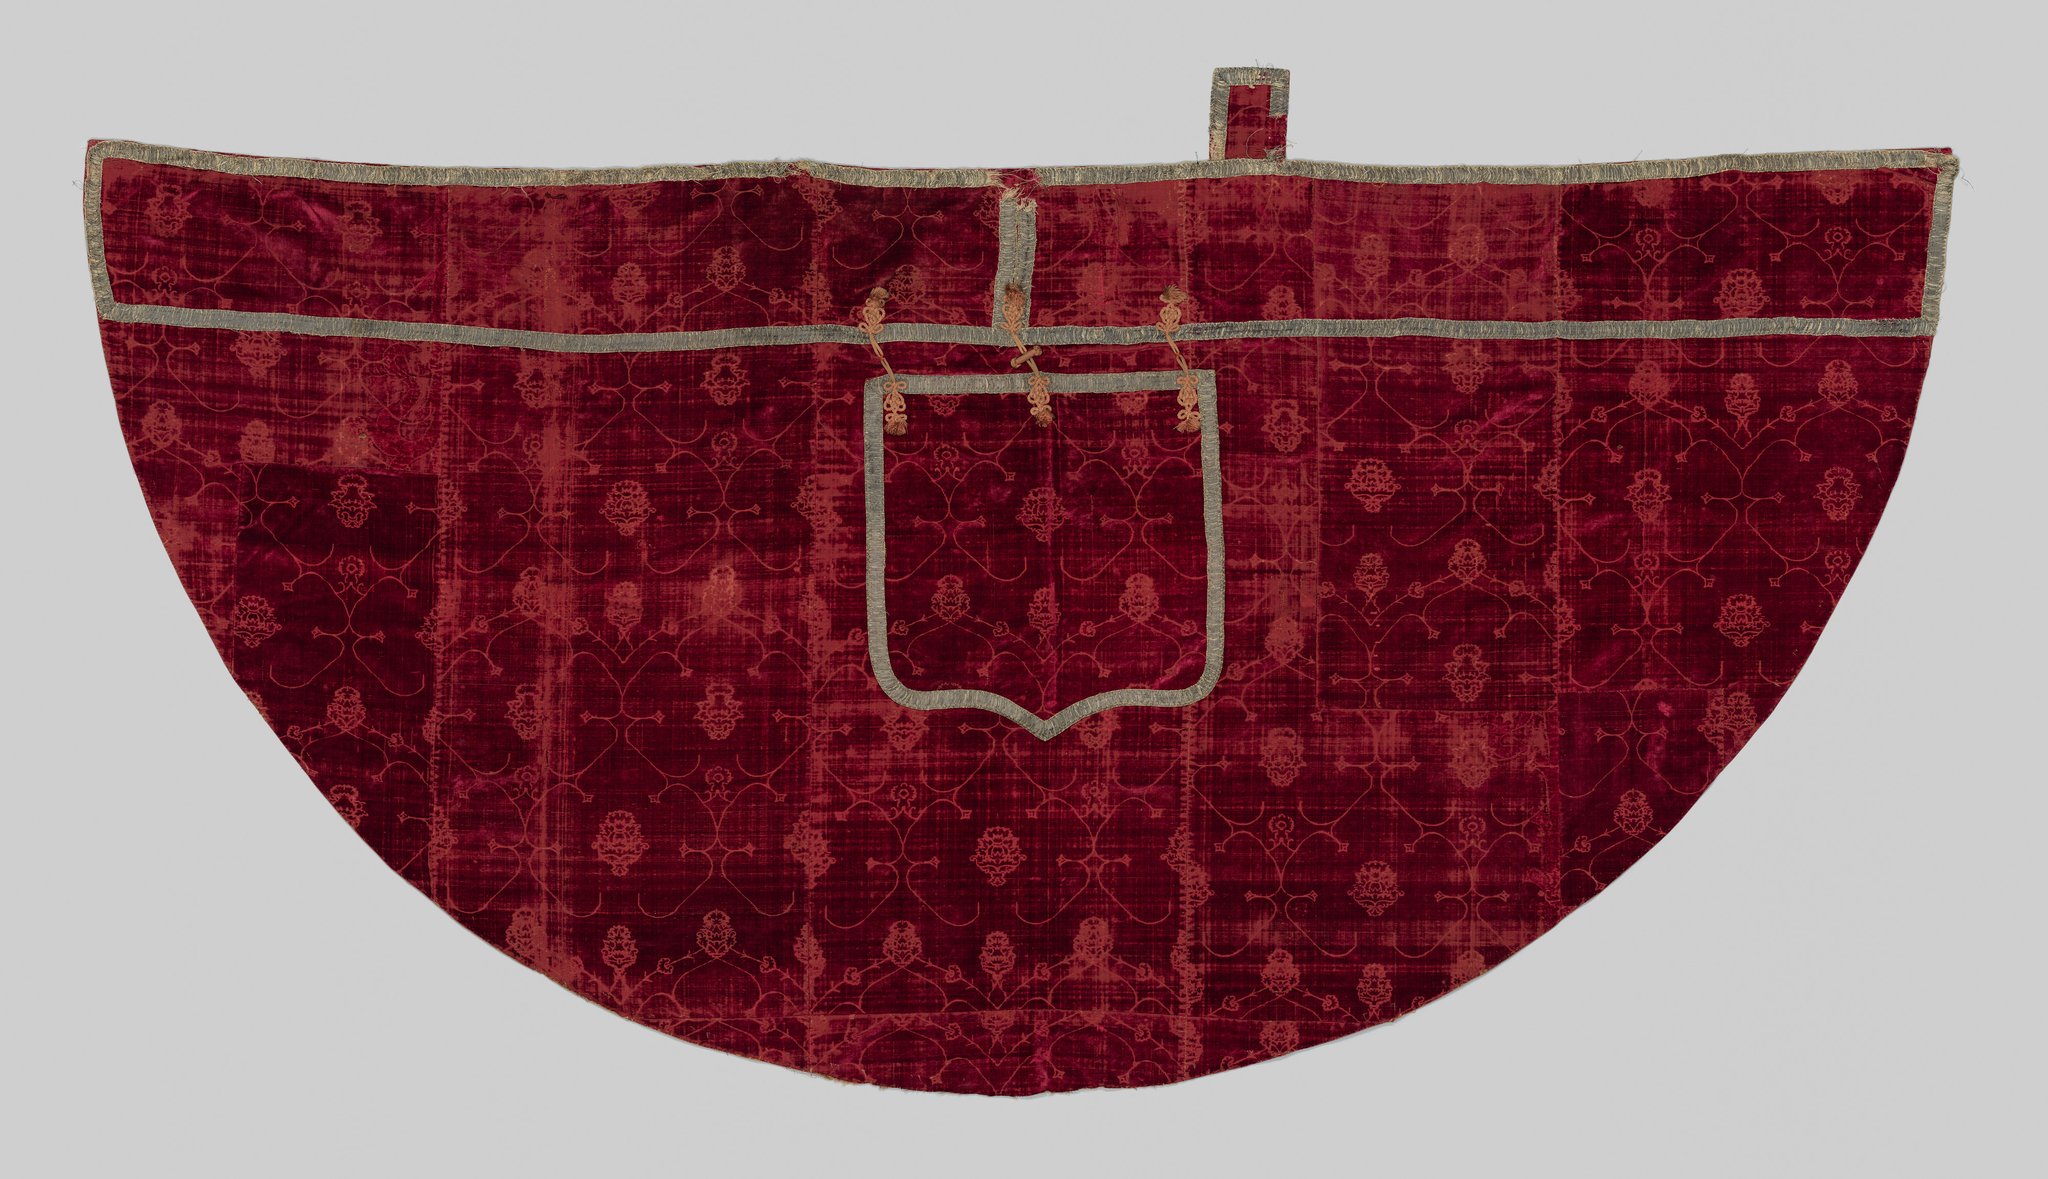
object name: cope with hood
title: Cope with a Hood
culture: italian or spanish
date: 1434-1466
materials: silk